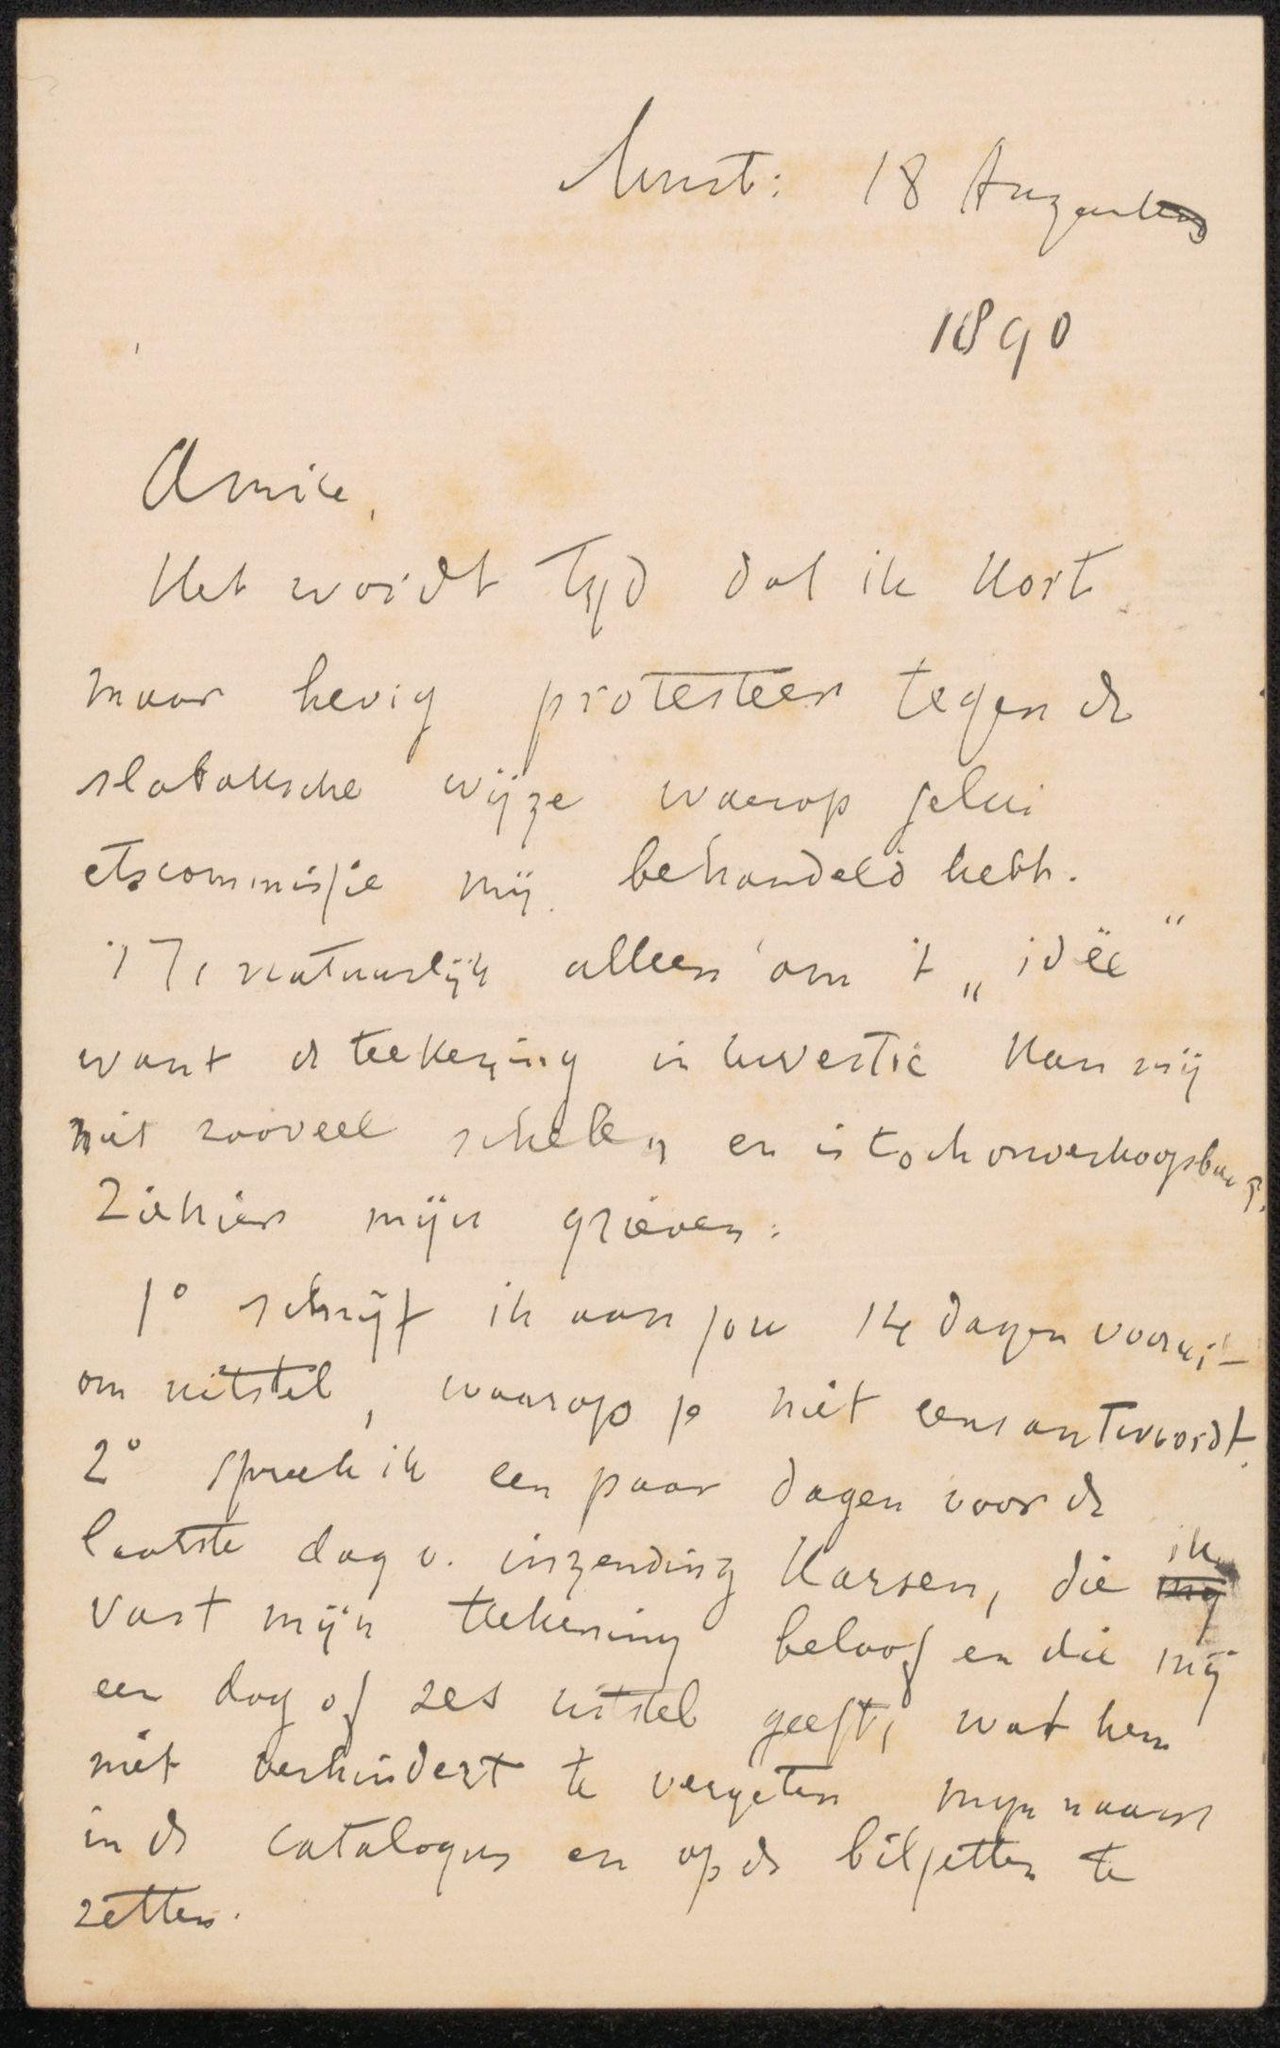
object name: letter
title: Brief aan Jan Veth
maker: isaac israels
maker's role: draughtsman, painter, print maker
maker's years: 1865-1934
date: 1875-1925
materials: ink, paper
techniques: pen, writing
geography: amsterdam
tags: dordrecht, designer, jan veth, painter, print maker, draughtsman, eduard karsen, drawing, passions, emotions, affections, money, printed matter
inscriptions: collector's mark: ‘RPK’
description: Gedateerd 18 Augustus. In latere hand 1890.